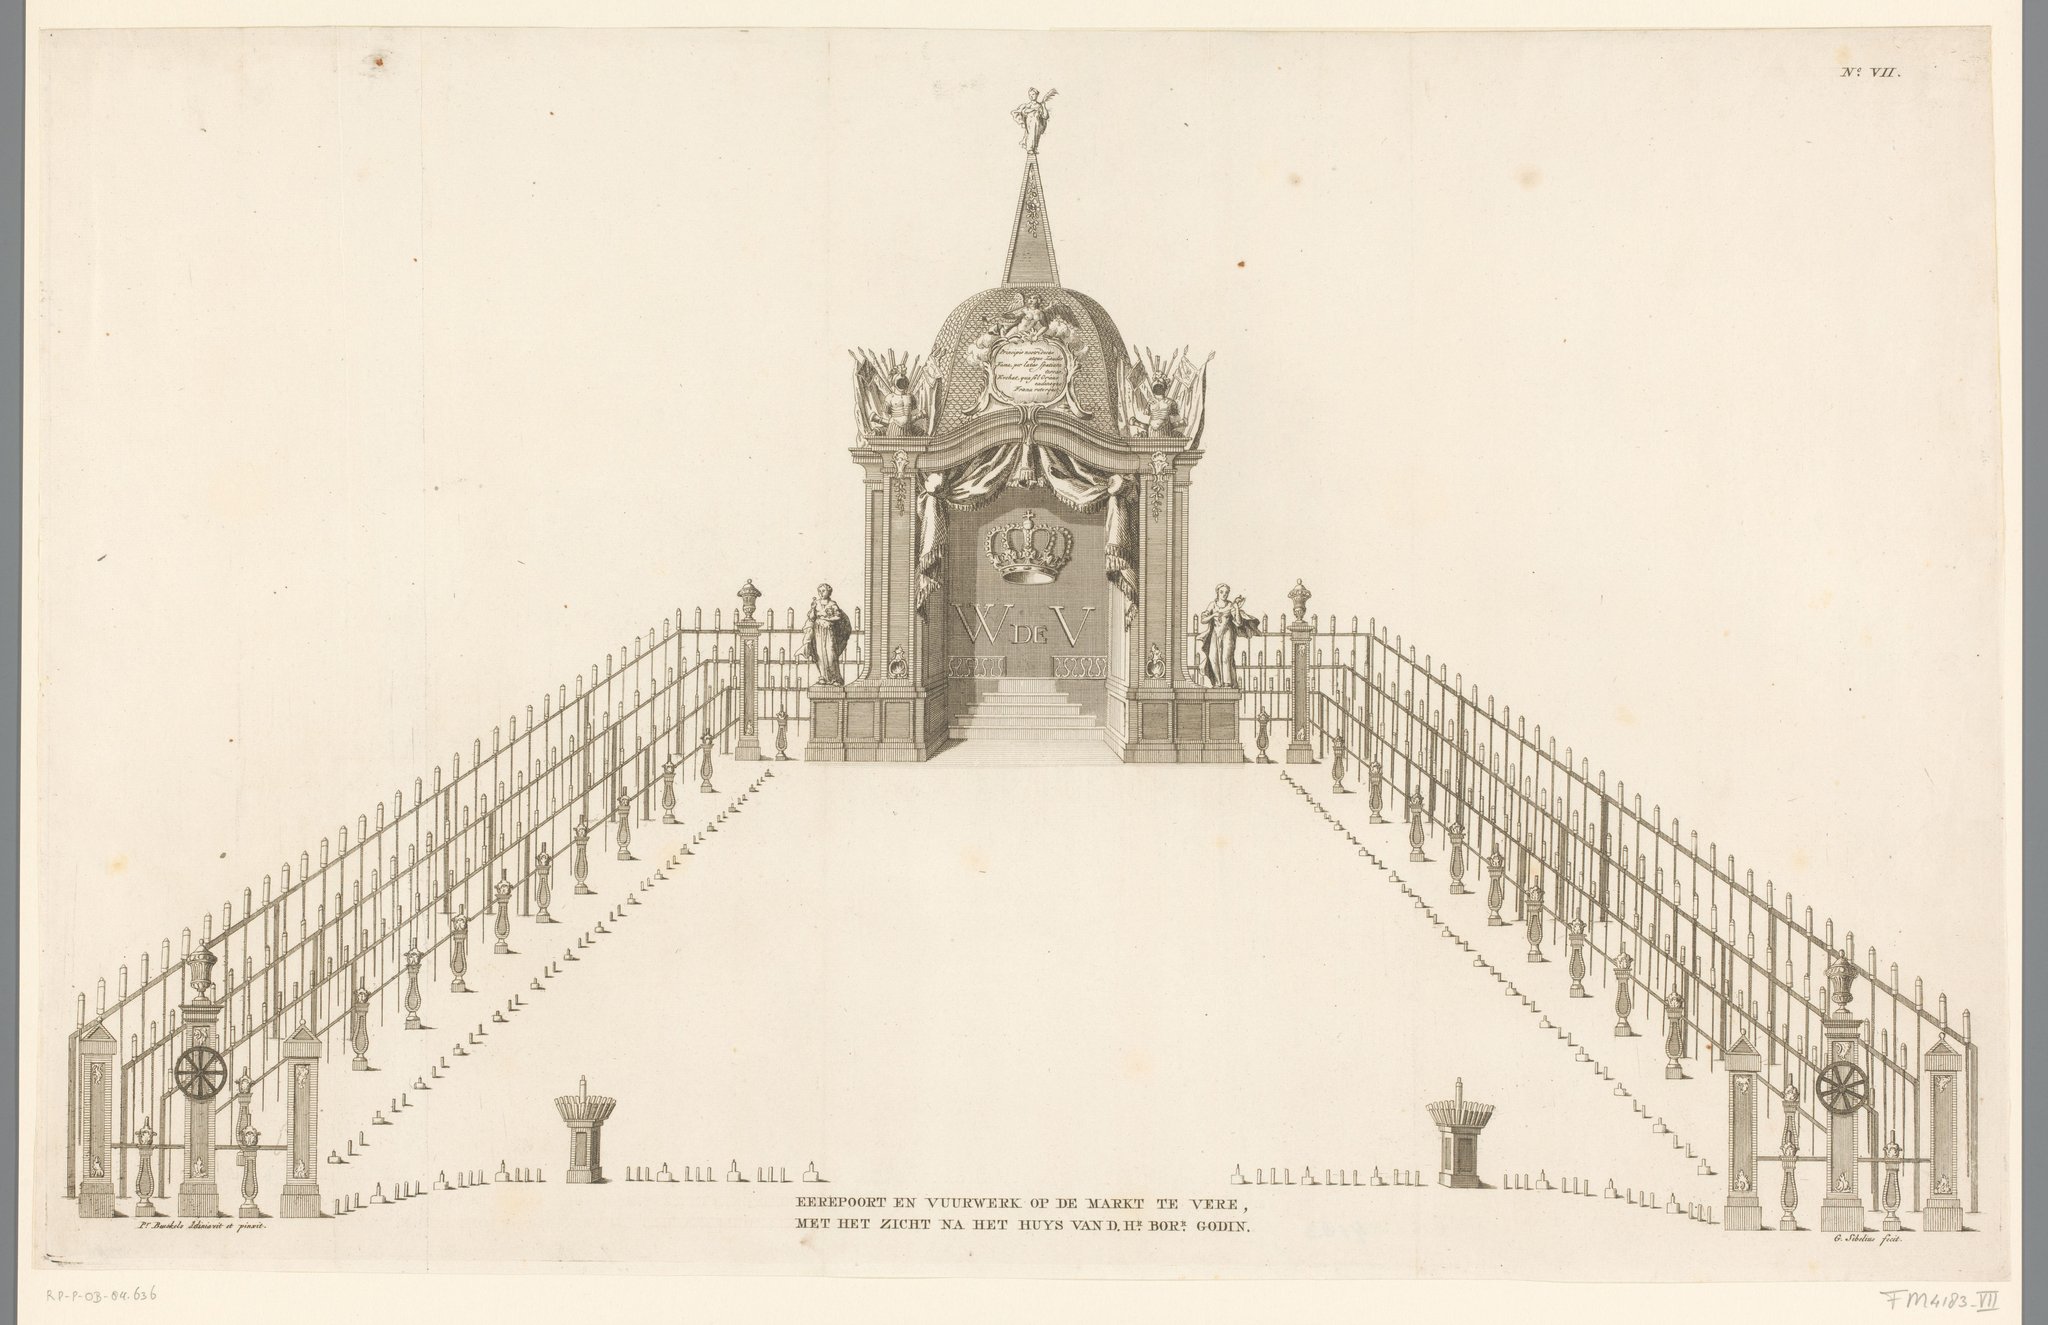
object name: print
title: Erepoorten bij de intocht van Willem V te Veere (Nr. VII), 1766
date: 1766-1767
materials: paper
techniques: engraving, etching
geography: northern netherlands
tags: the hague, william v (prince of orange), triumphal arch, bonfire, fire-works (+ illumination, fire-works ~ festive activities)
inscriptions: collector's mark: Lugt 2228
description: De erepoort met de stellage voor het vuurwerk opgericht op de Markt te Veere. Onderdeel van een groep van 10 platen van de decoraties te Veere ter gelegenheid van de inhuldiging van stadhouder Willem V als Markgraaf van Veere, 28 mei 1766. Genummerd rechtsboven: No. VII.